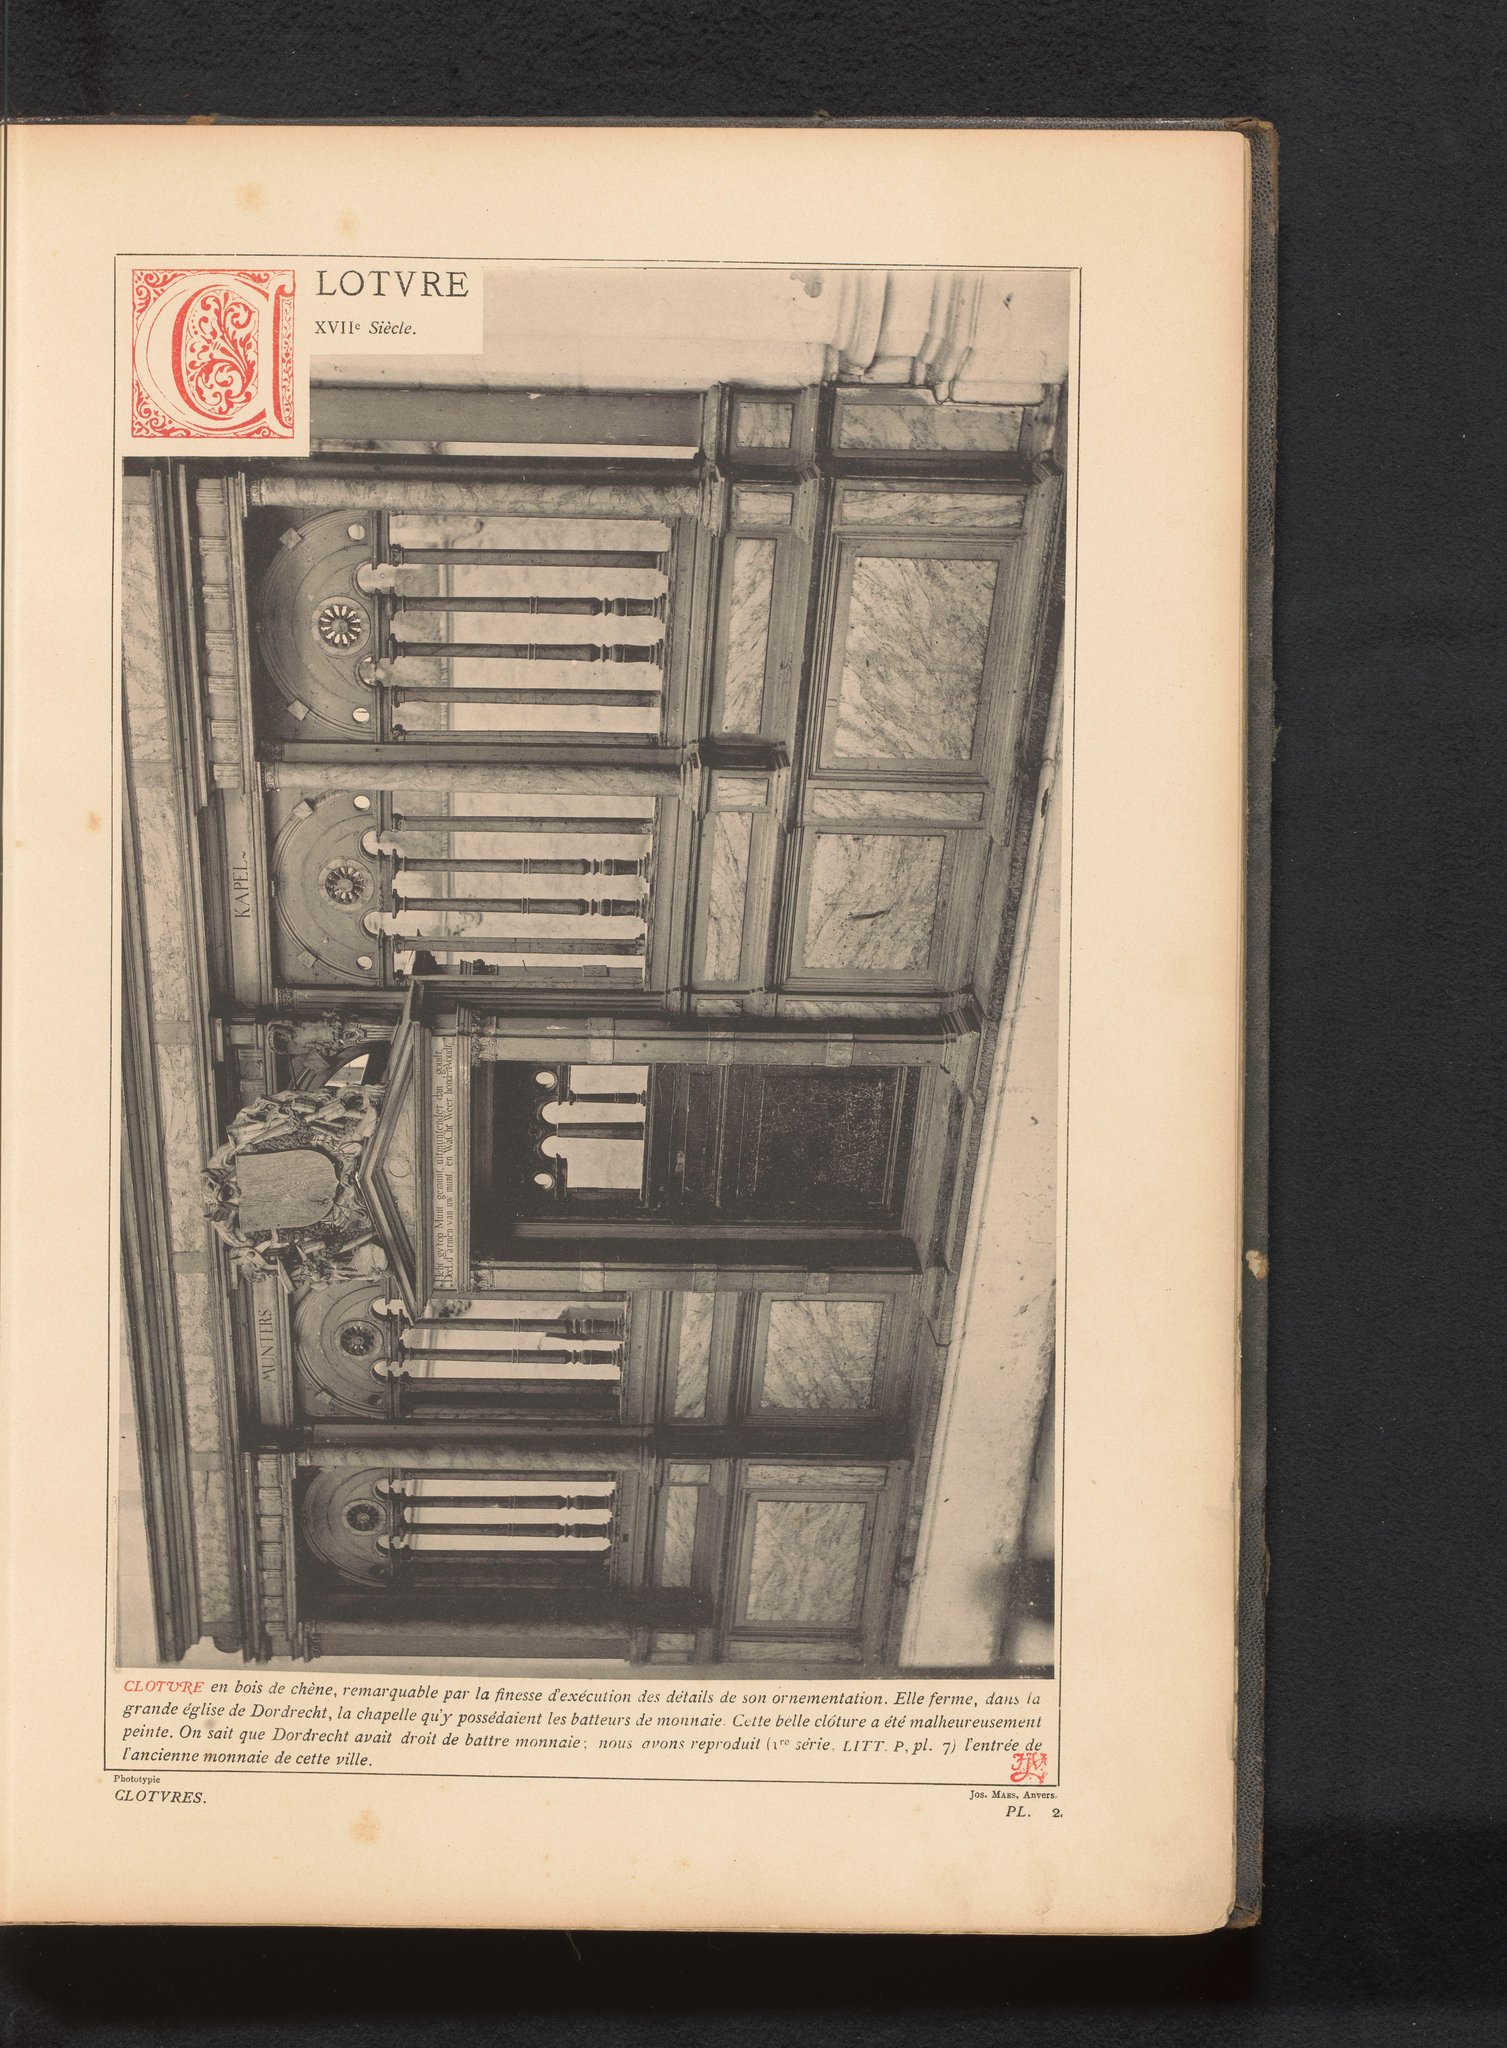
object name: page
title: Cloture, XVIIe Siècle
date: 1881-1889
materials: paper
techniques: photograph, photolithography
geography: dordrecht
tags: interior of church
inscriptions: inscription: ‘COTURES. PL. 2.’, inscription: ‘CLOTURE en bois (...)’, monogram: ‘JJvY’